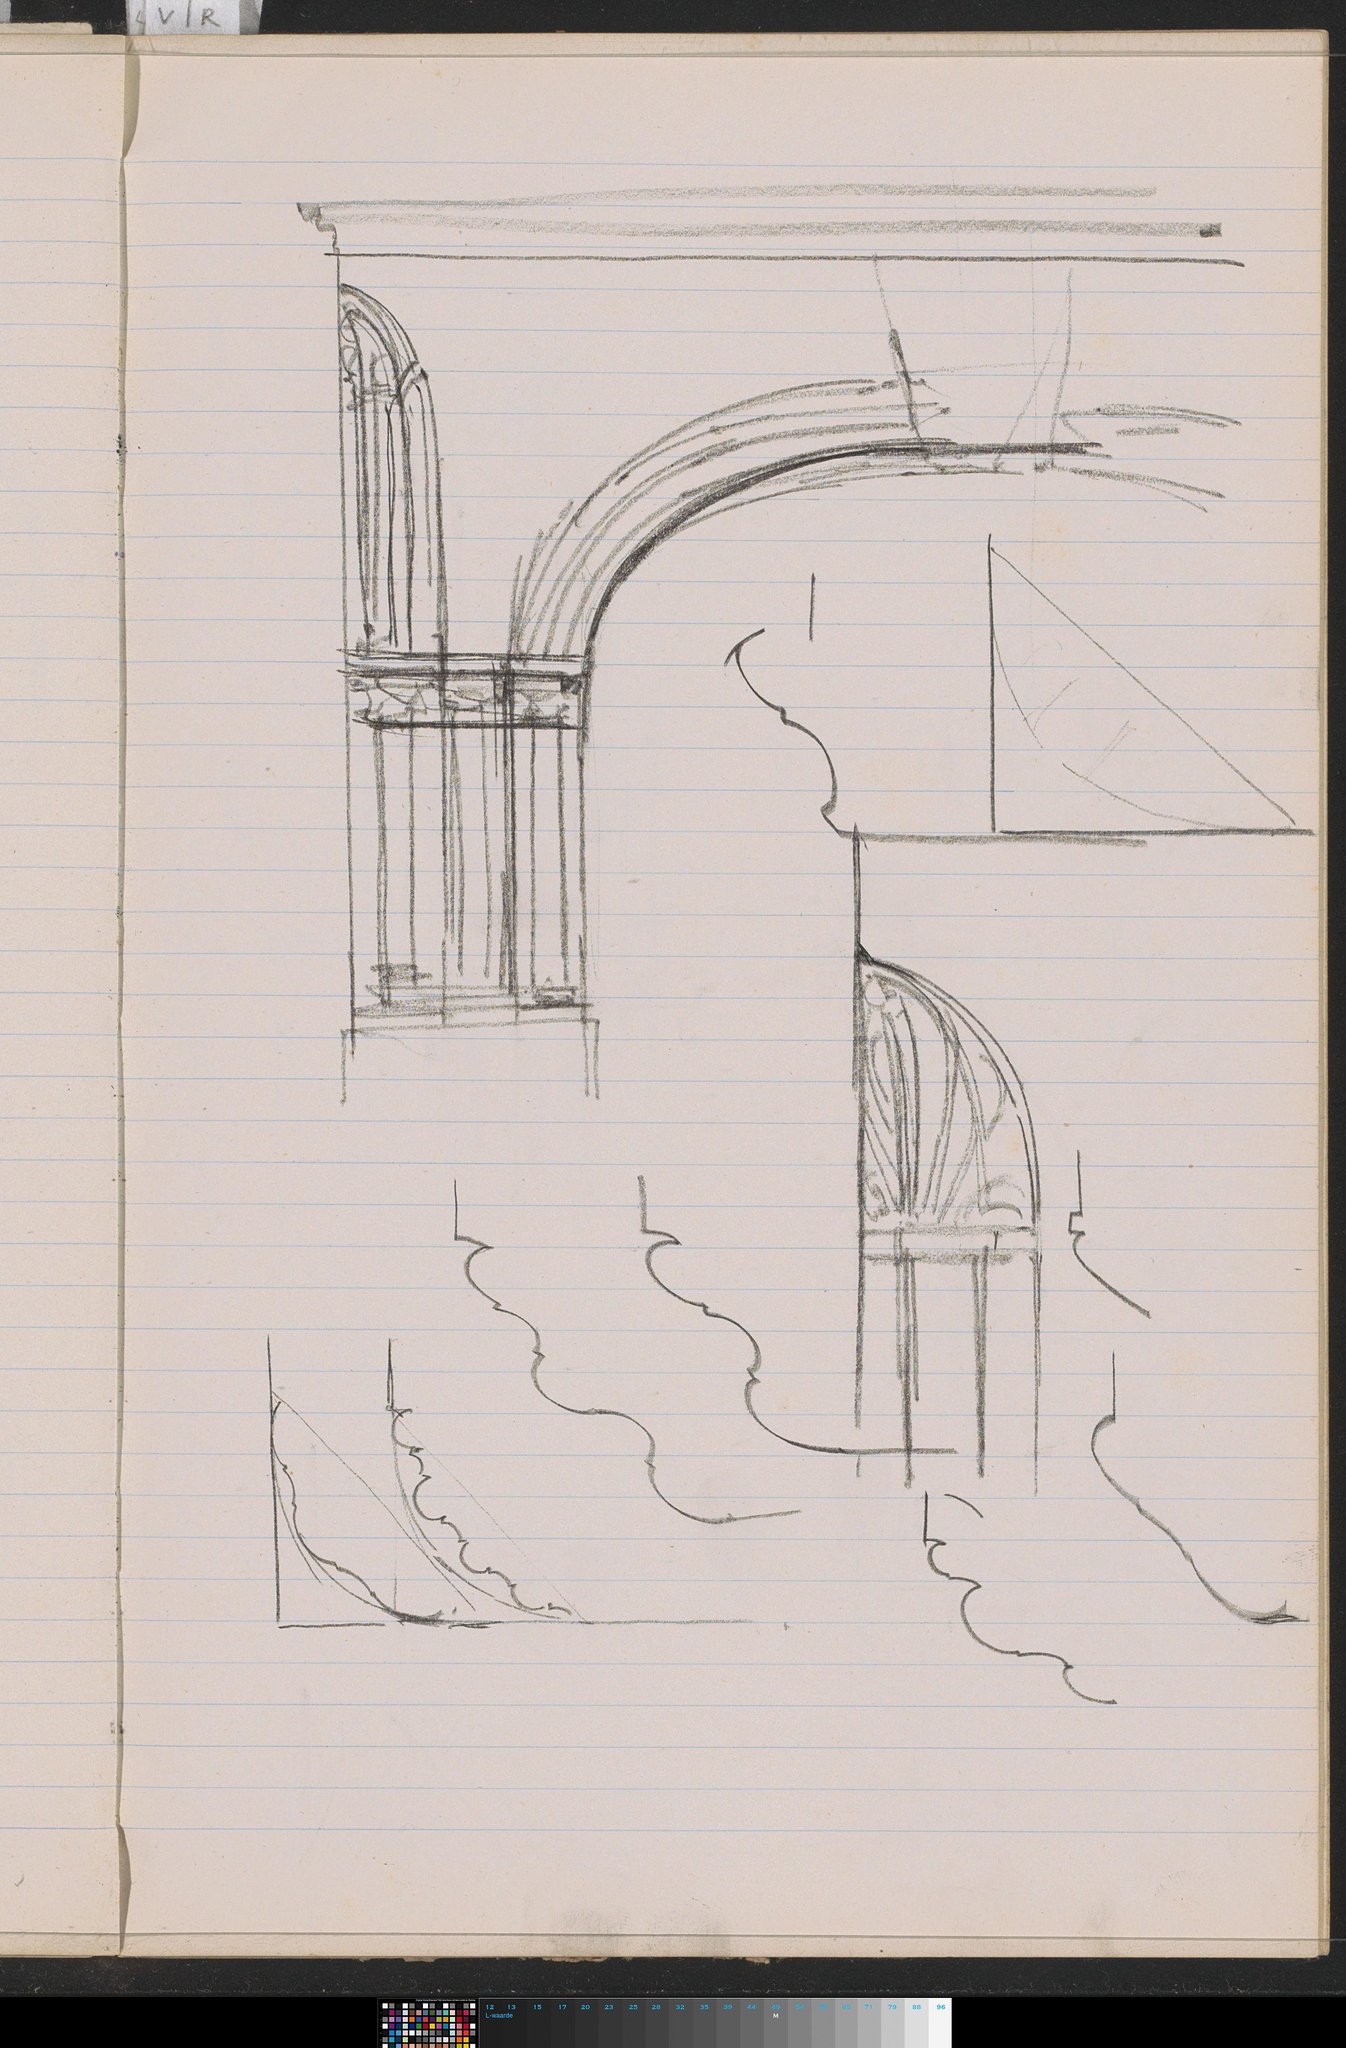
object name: sketchbook leaf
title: Triomfboog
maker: gerrit willem dijsselhof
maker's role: designer, draughtsman, print maker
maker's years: 1866-1924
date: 1901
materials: chalk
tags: architectural detail, triumphal arch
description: Tevens architectuurstudies. Blad 41 recto uit een schetsboek met 79 bladen.